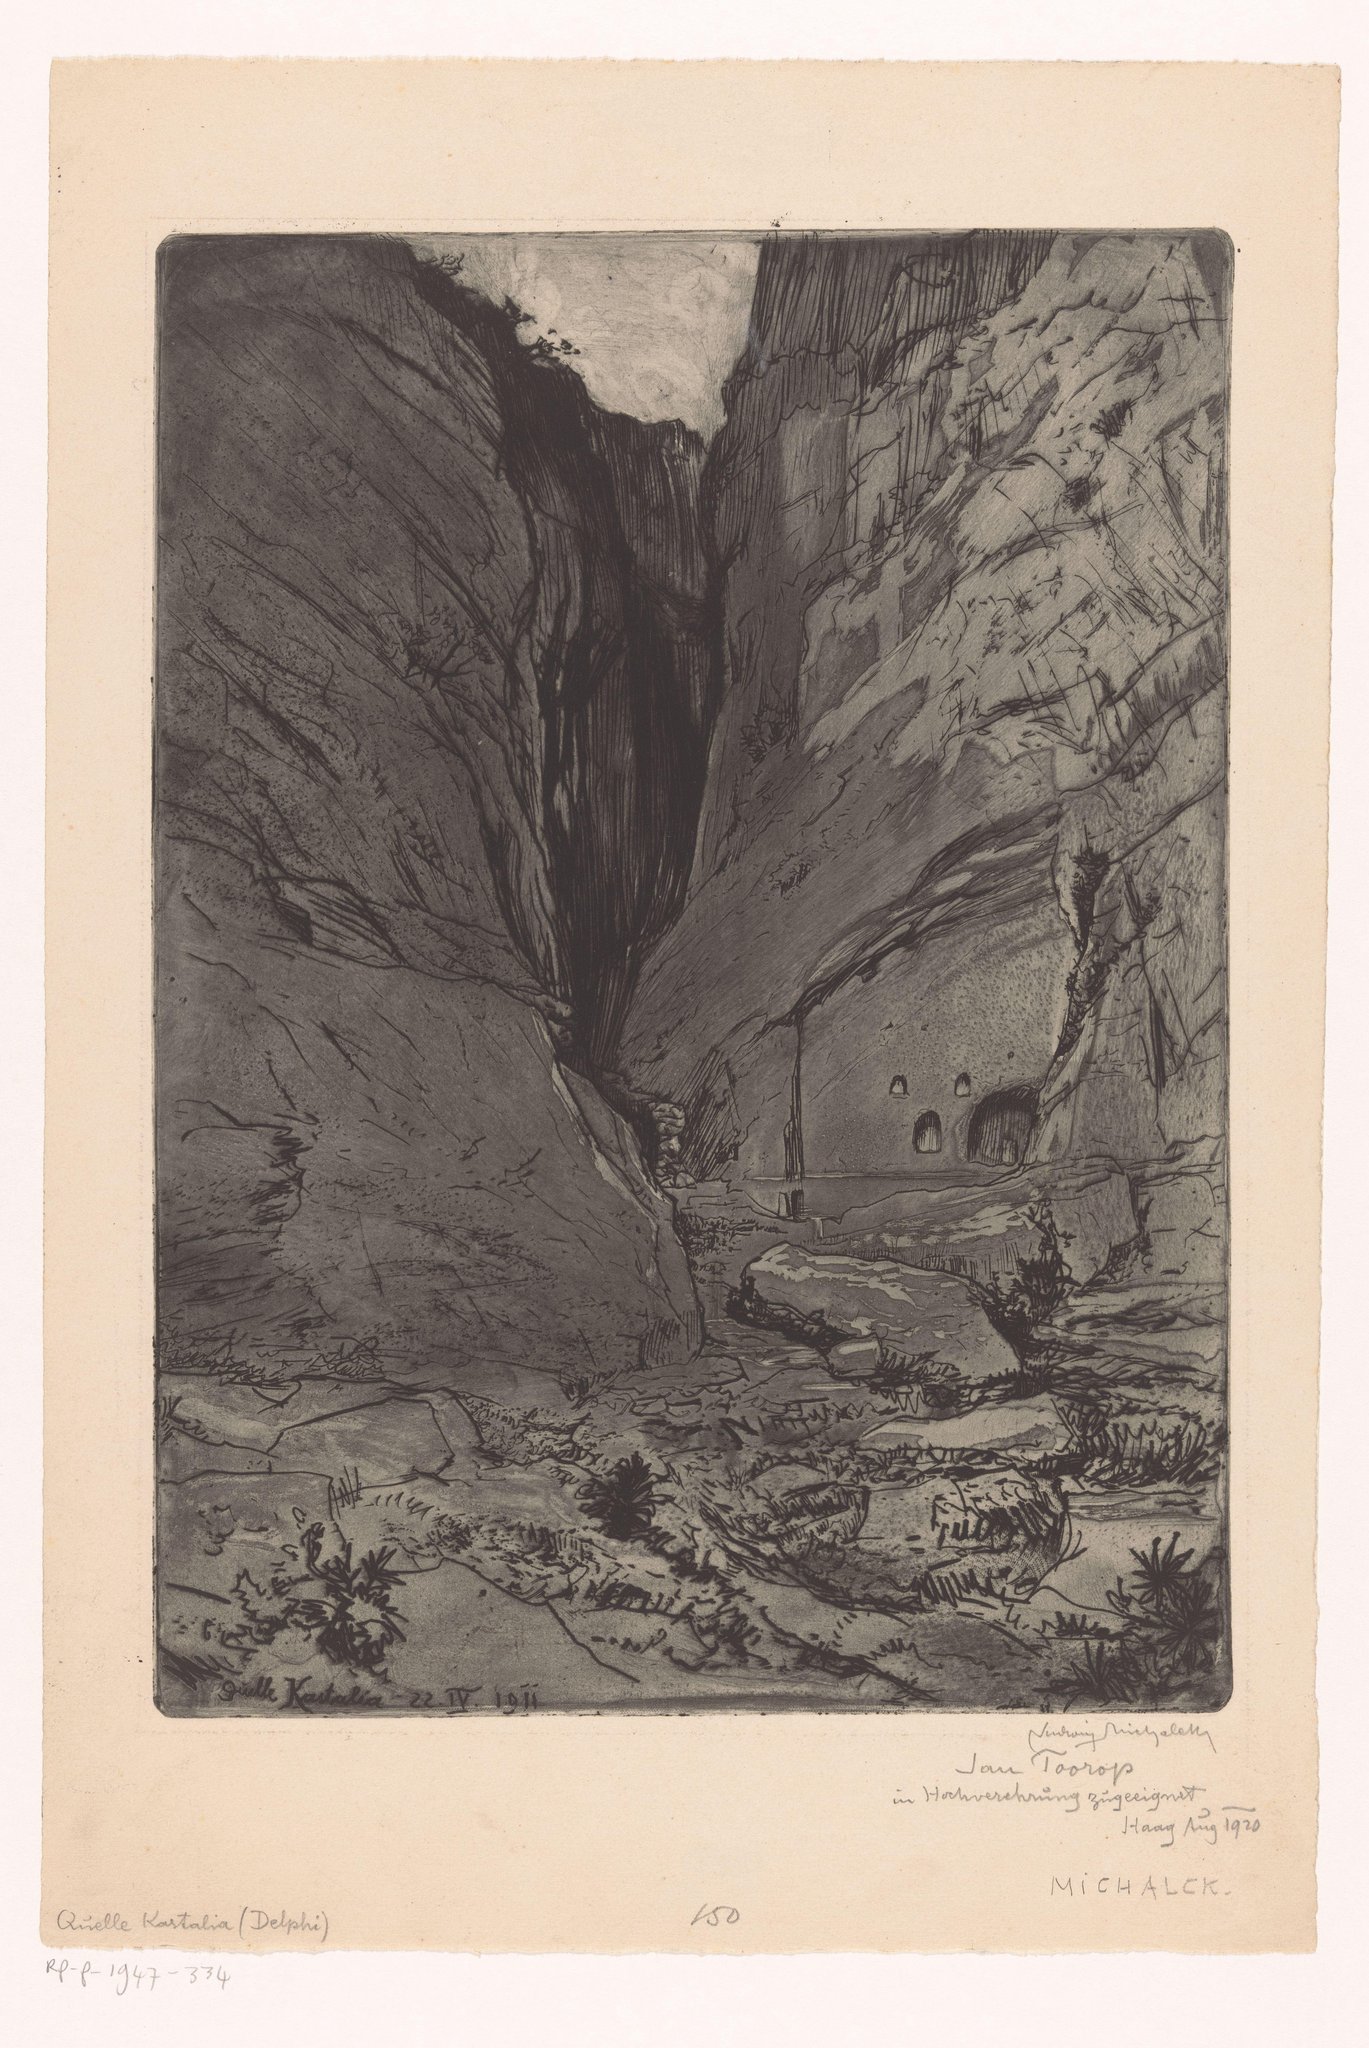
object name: print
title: Kastalische bron bij Delphi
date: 1911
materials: paper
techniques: aquatint, etching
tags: ravine, chasm, abyss, canyon, spring, source of river or stream, castalian spring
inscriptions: dedication: ‘Jan Toorop in Hogverehrüng zugeeignet Haag Aug 1920’, collector's mark: Lugt 2228, signature: ‘Ludwig Michalek’